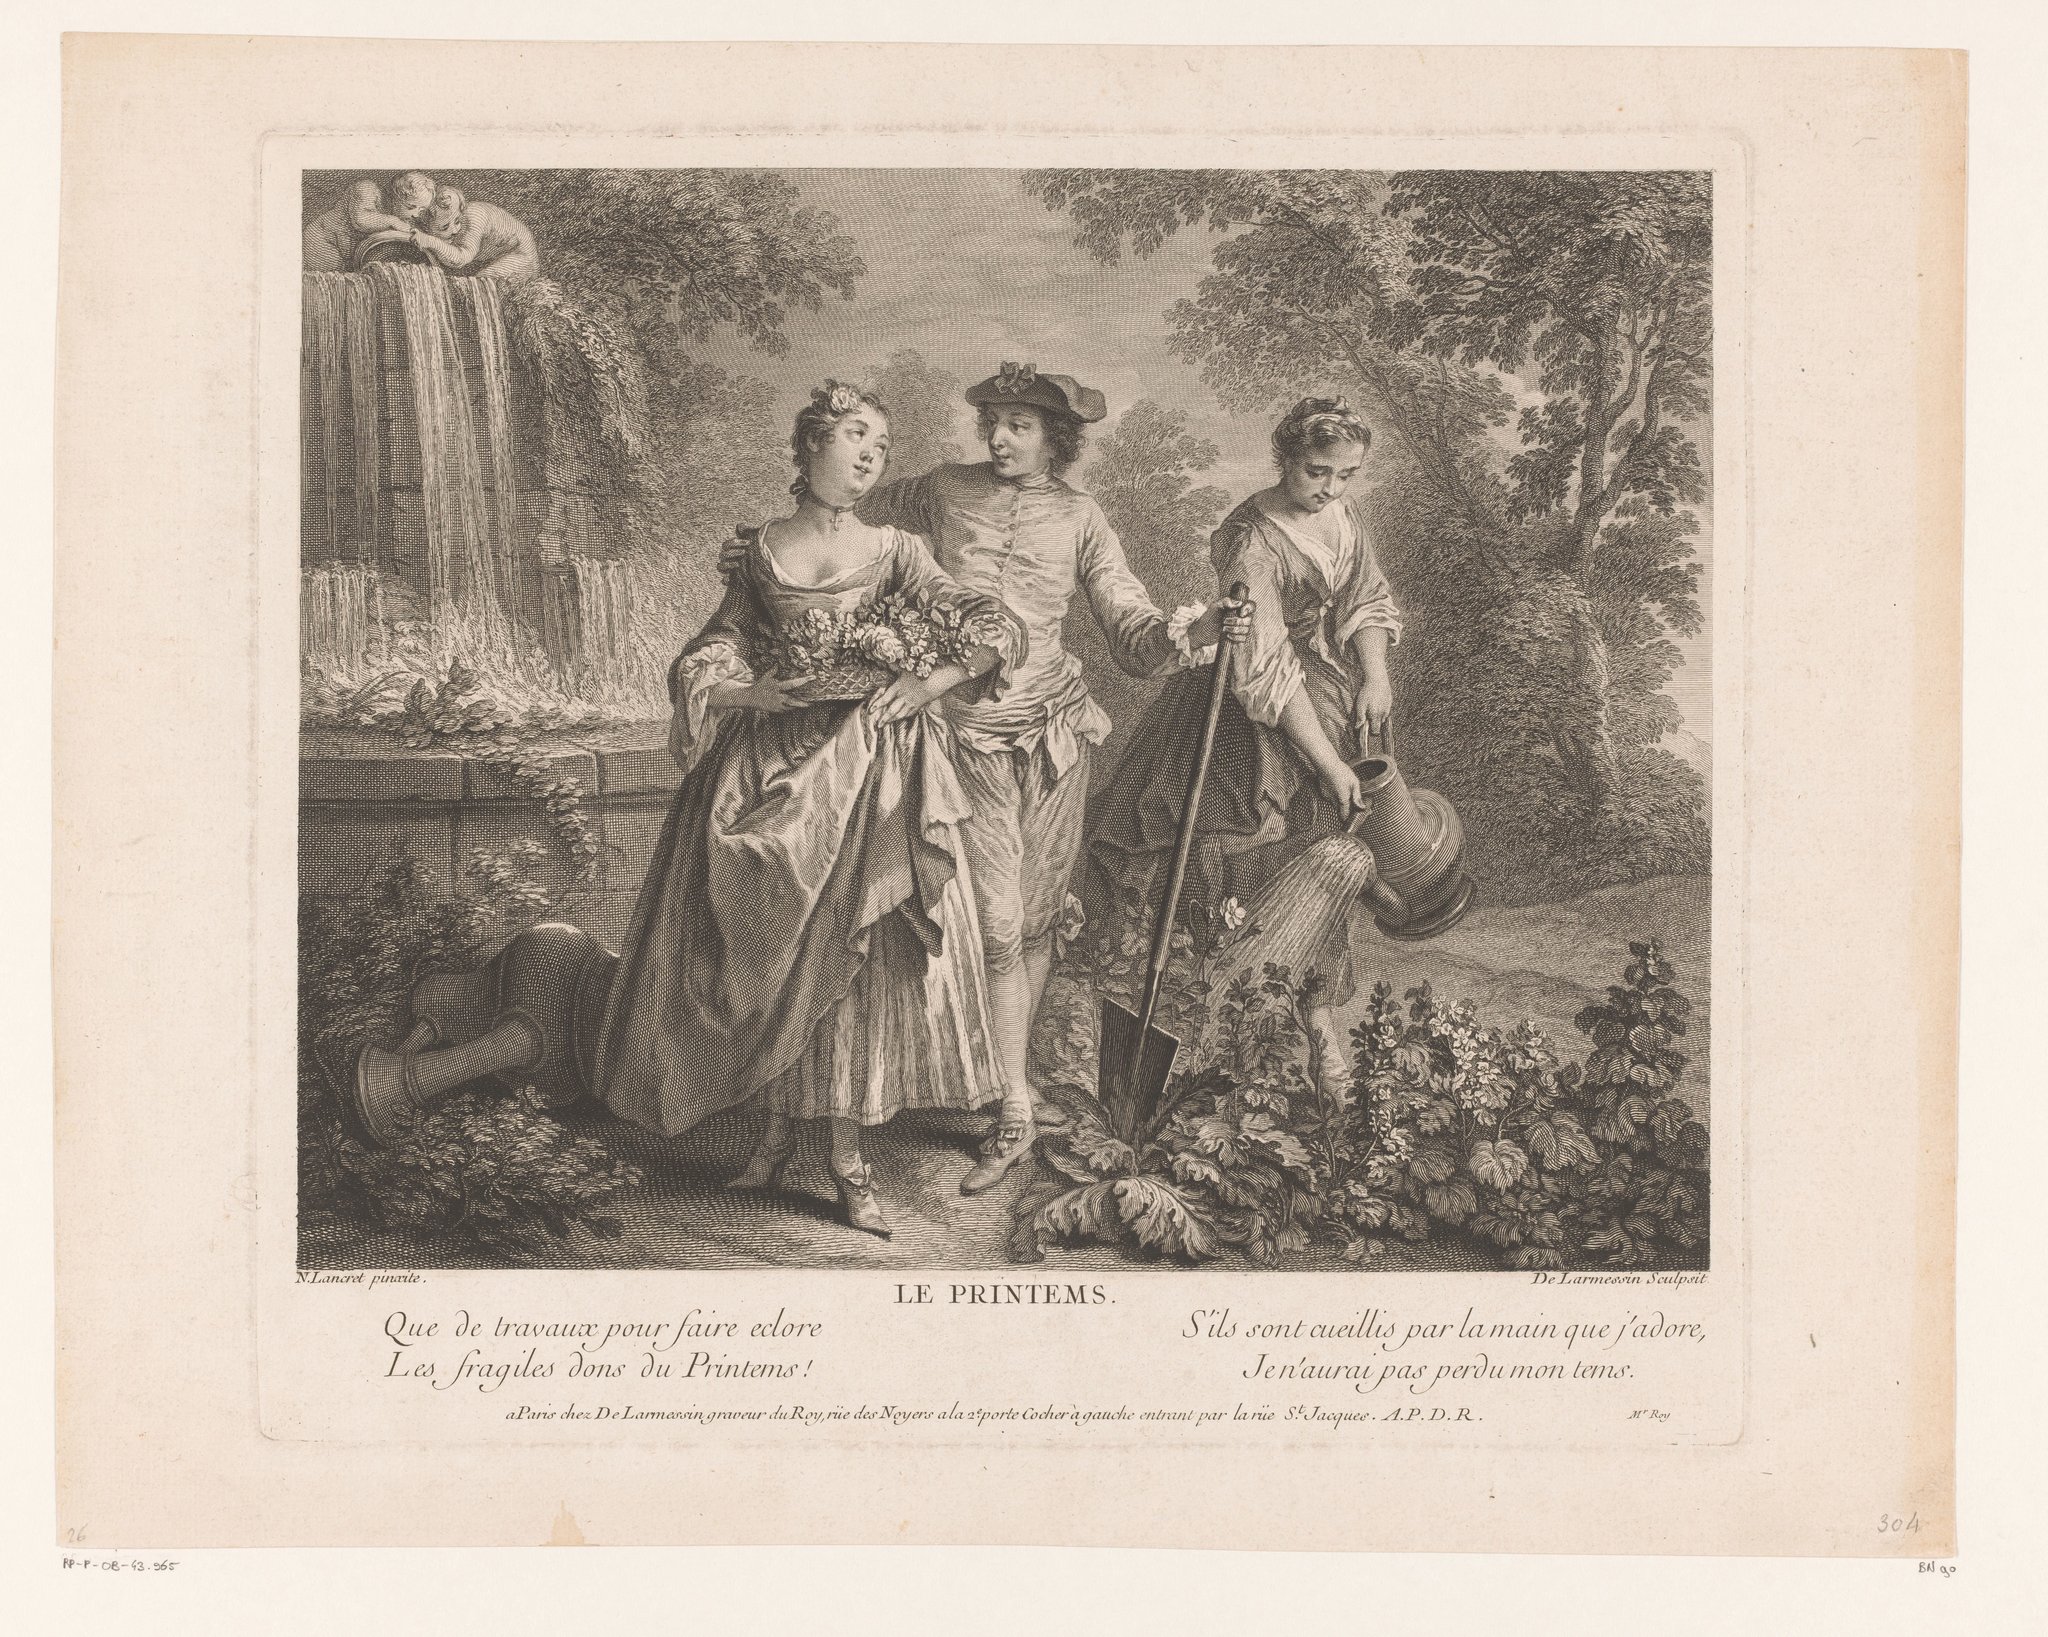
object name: print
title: De vier seizoenen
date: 1745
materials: paper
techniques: engraving, etching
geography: paris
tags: garden fountain, spring ~ human activities (the four seasons of the year), gardening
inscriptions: collector's mark: Lugt 240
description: Drie tuinierende figuren in een tuin bij een fontein. Links een vrouw met een mand met bloemen, in het midden een man met een schep en rechts een vrouw met een gieter.